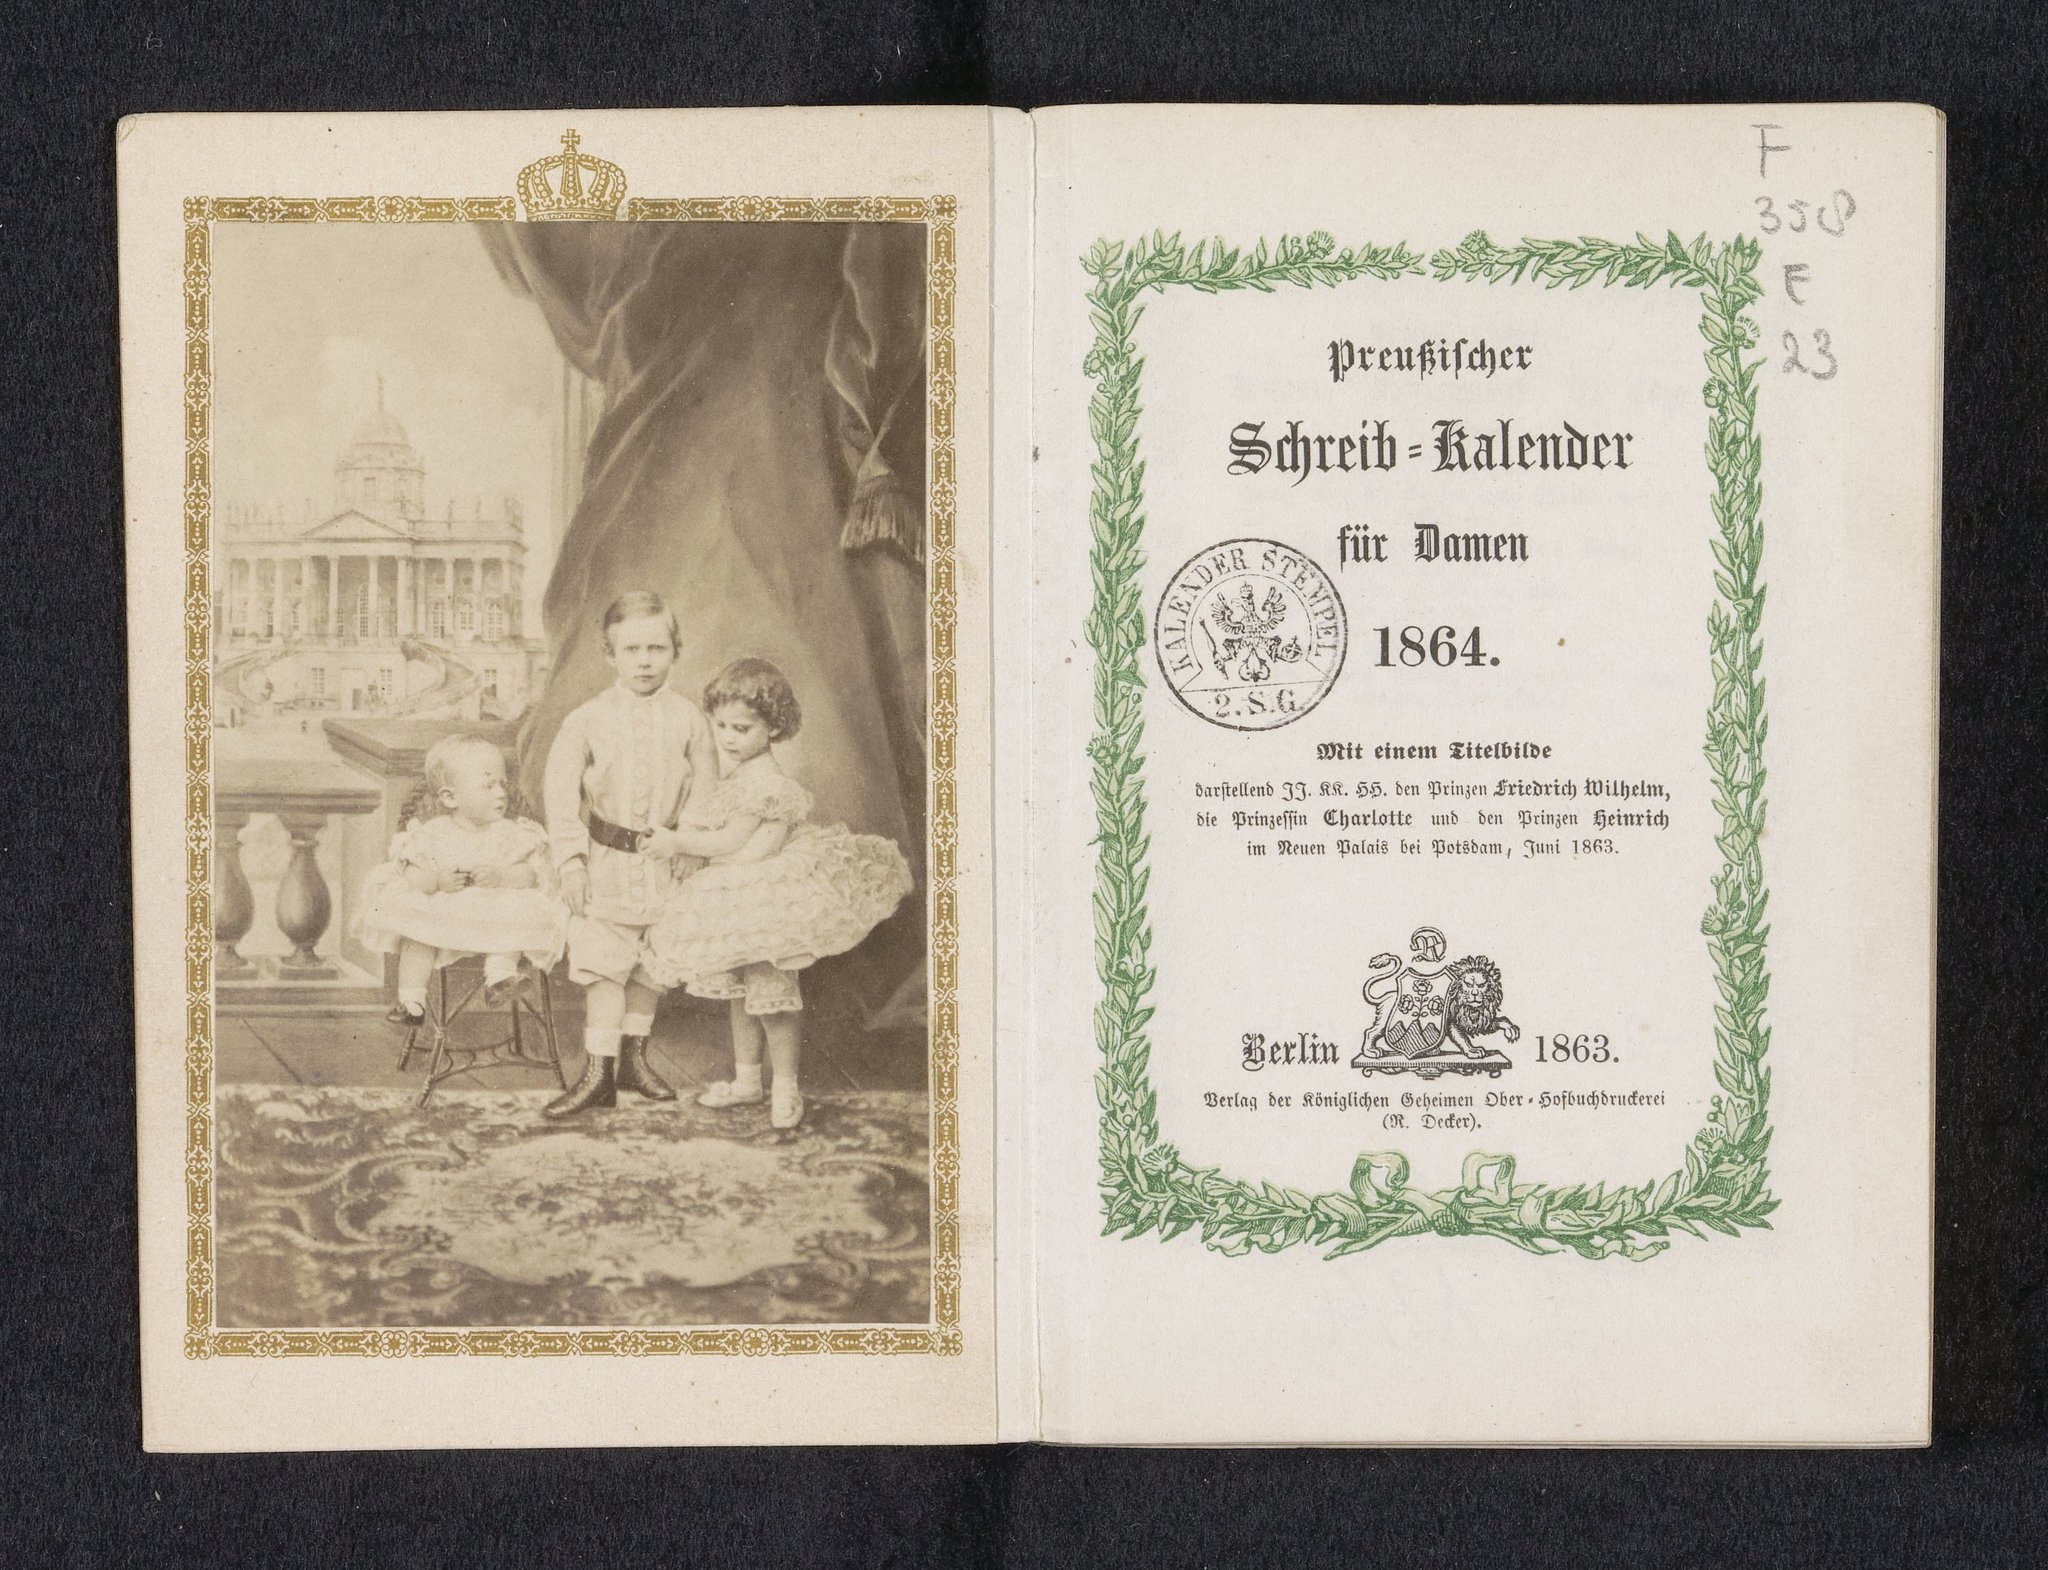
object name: book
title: Preussischer Schreib-Kalender für Damen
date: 1863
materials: paper, photographic support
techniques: albumen print, printing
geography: berlin